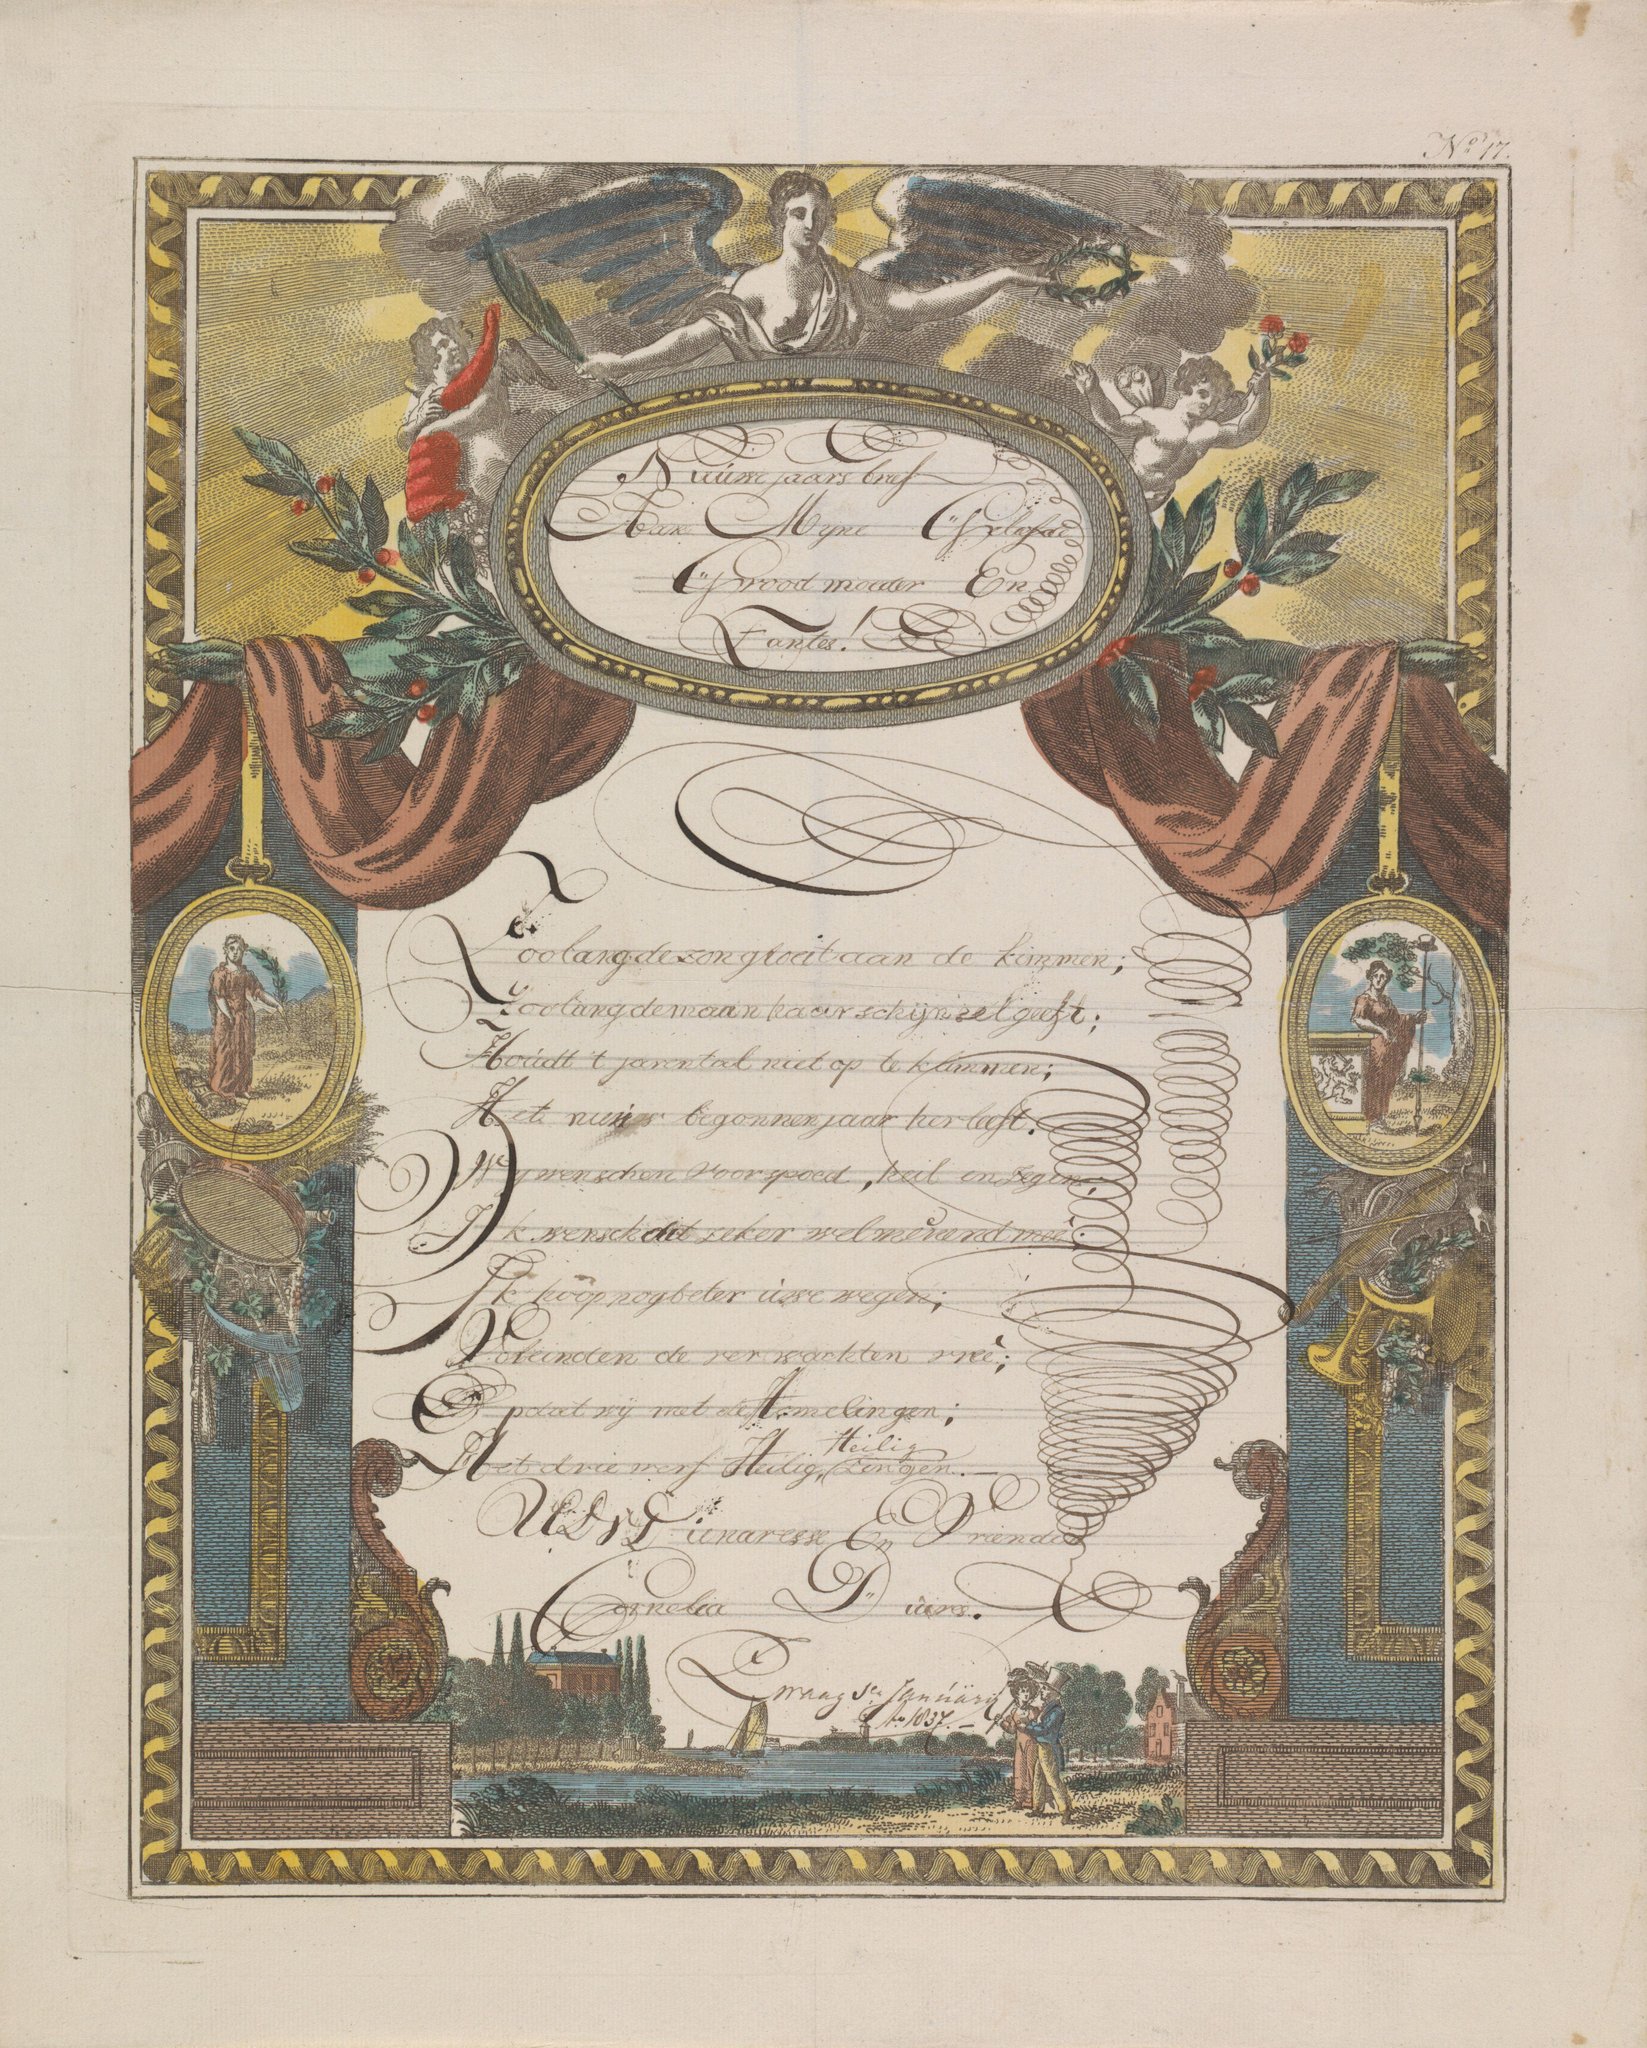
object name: popular print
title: Wensbrief met engel en minnend paar bij een rivier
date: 1792-1847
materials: ink, paper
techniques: calligraphy, colour, etching, pen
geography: amsterdam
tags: river, couple of lovers, angels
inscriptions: inscription: ‘Nieuwe jaars brief / Aan miojne geliefde / Groodmoeder en / Tantes! / Zoolang de zon gloeit aan de [...] ...’, collector's mark: Lugt 2760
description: Wensbrief met beschreven cartouche binnen een decoratief kader met voorstellingen van een engel en een minnend paar bij een rivier met boot. Handgeschreven bericht in kalligrafie (Nieuwjaarsbrief) door Cornelia Duives aan haar grootmoeder en haar tantes. Genummerd rechtsboven: No. 17.